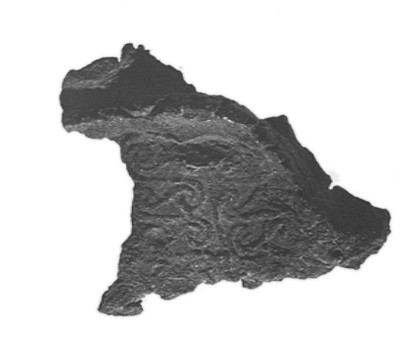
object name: sealing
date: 2030-1640 BCE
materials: clay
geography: egypt